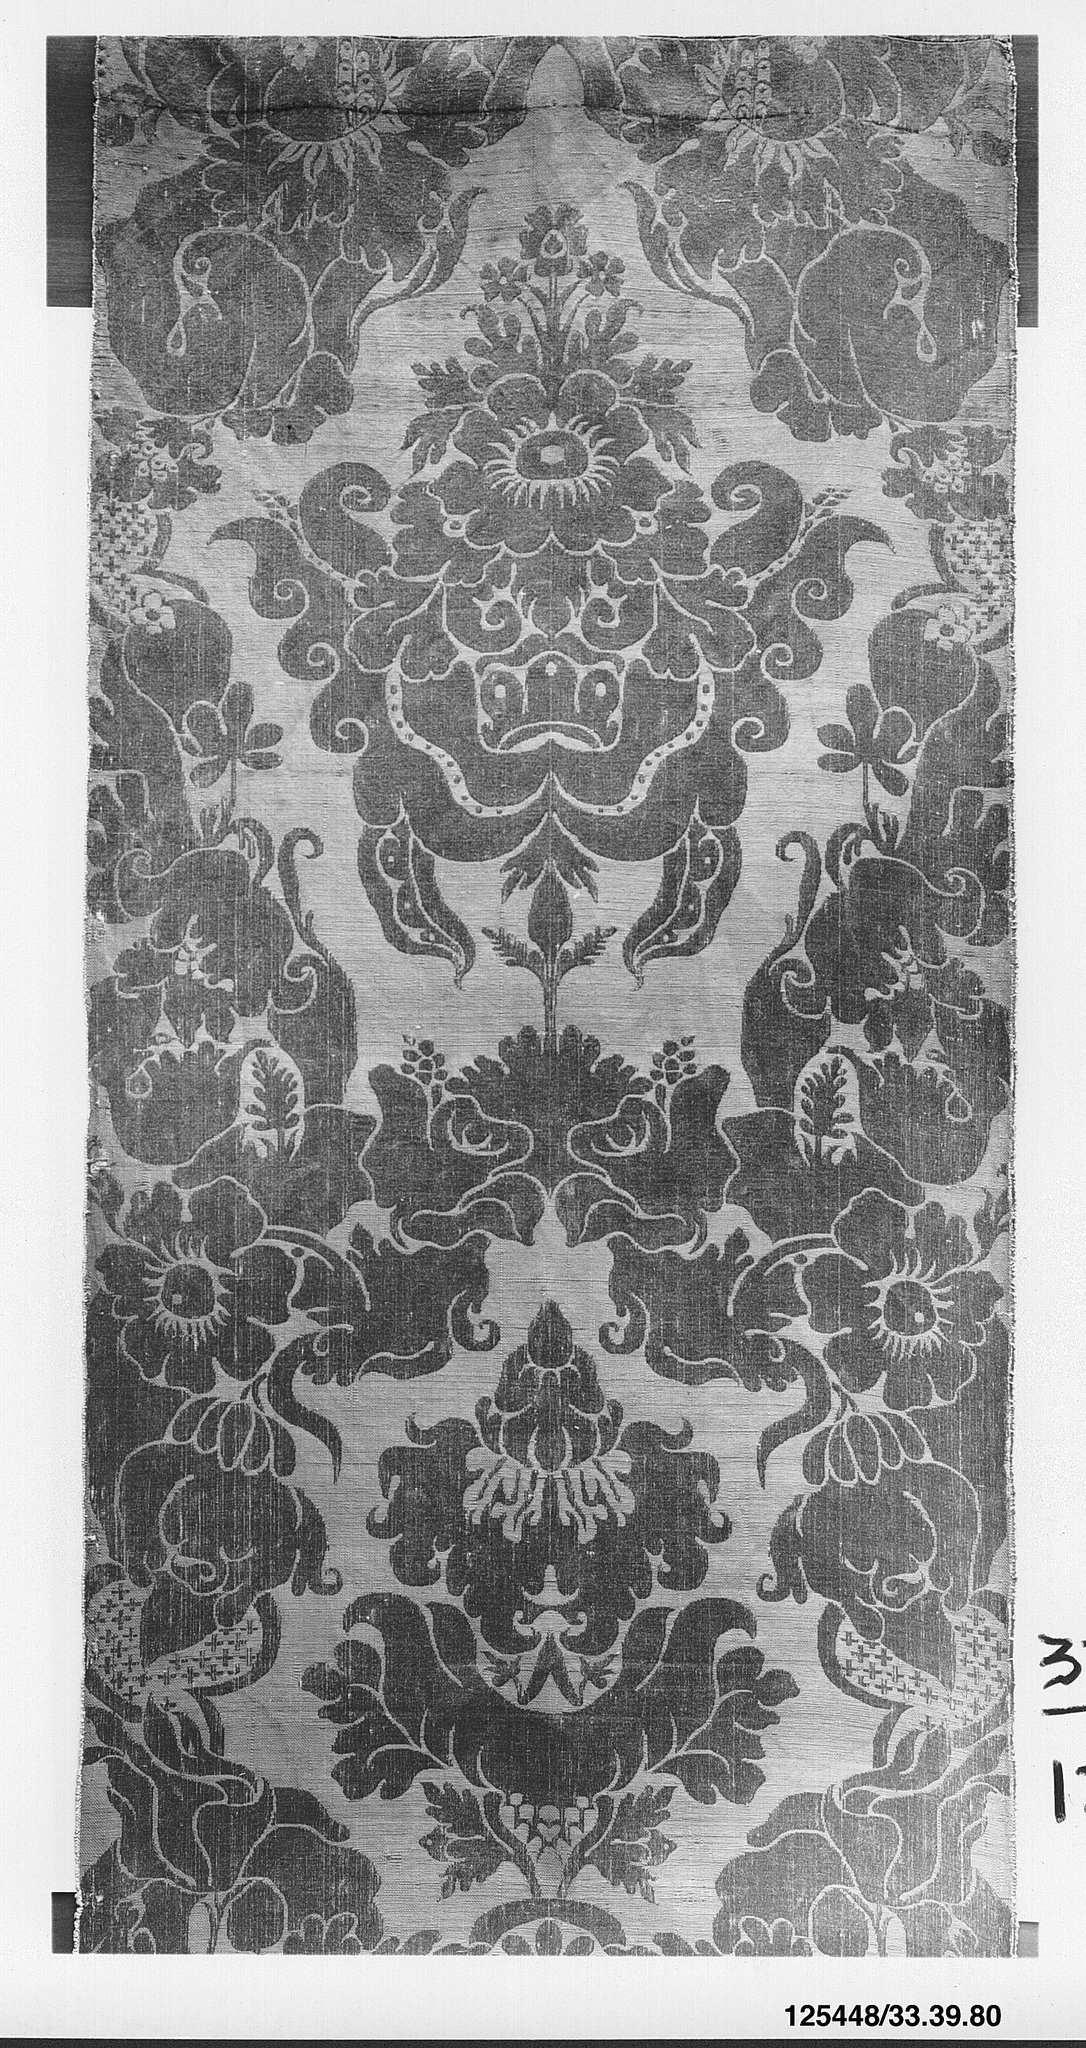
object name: piece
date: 1710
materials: linen, silk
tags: flowers